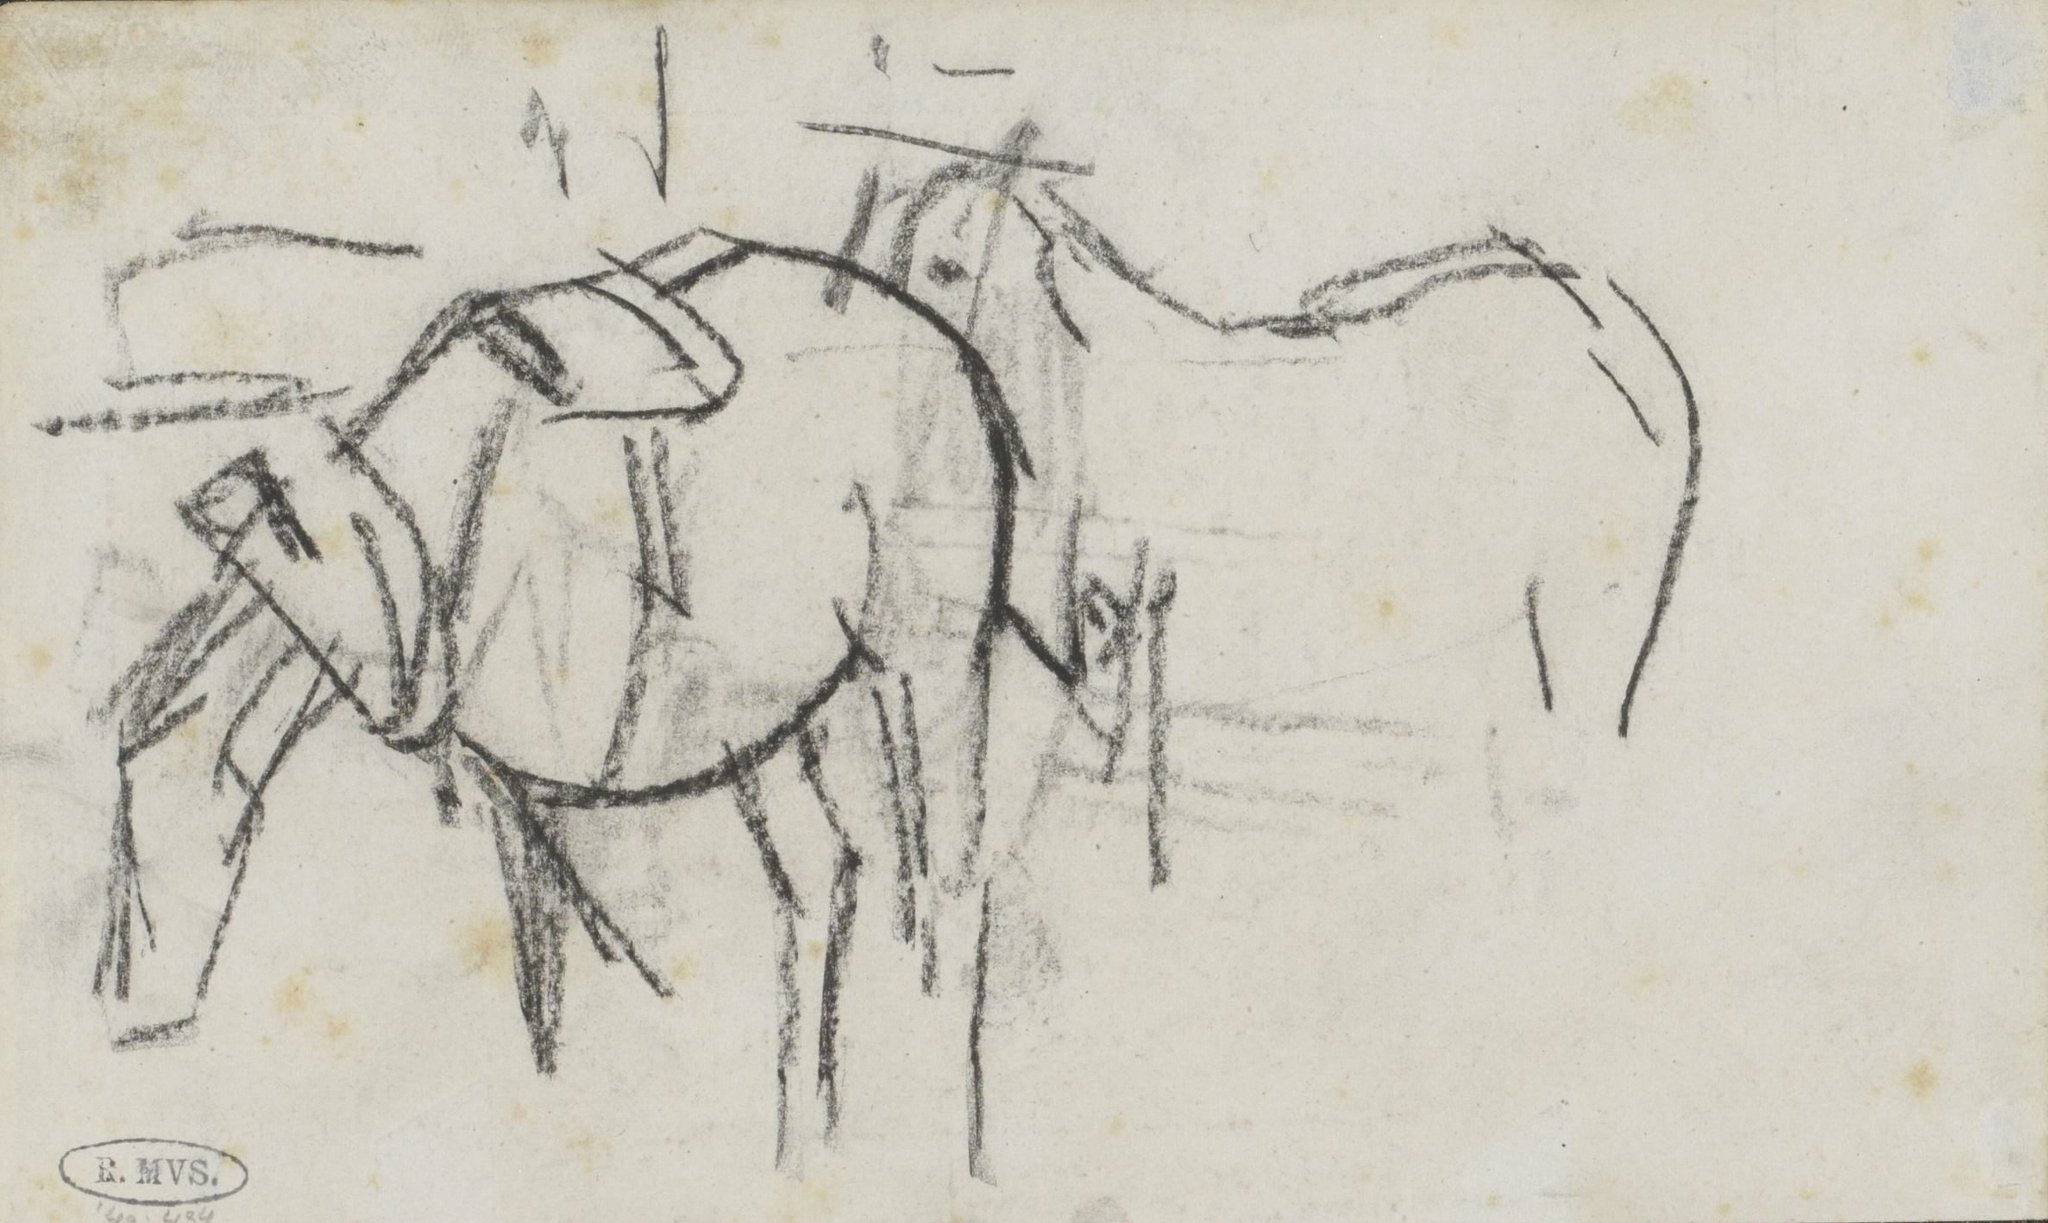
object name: drawing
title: Twee paarden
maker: george hendrik breitner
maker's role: draughtsman, painter, print maker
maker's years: 1857-1923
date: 1886-1903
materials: chalk, paper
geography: amsterdam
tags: hoofed animals (+ animals eating and drinking), horse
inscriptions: collector's mark: Lugt 2228, annotation: ‘Willempie Beek 15 jaar[?]’